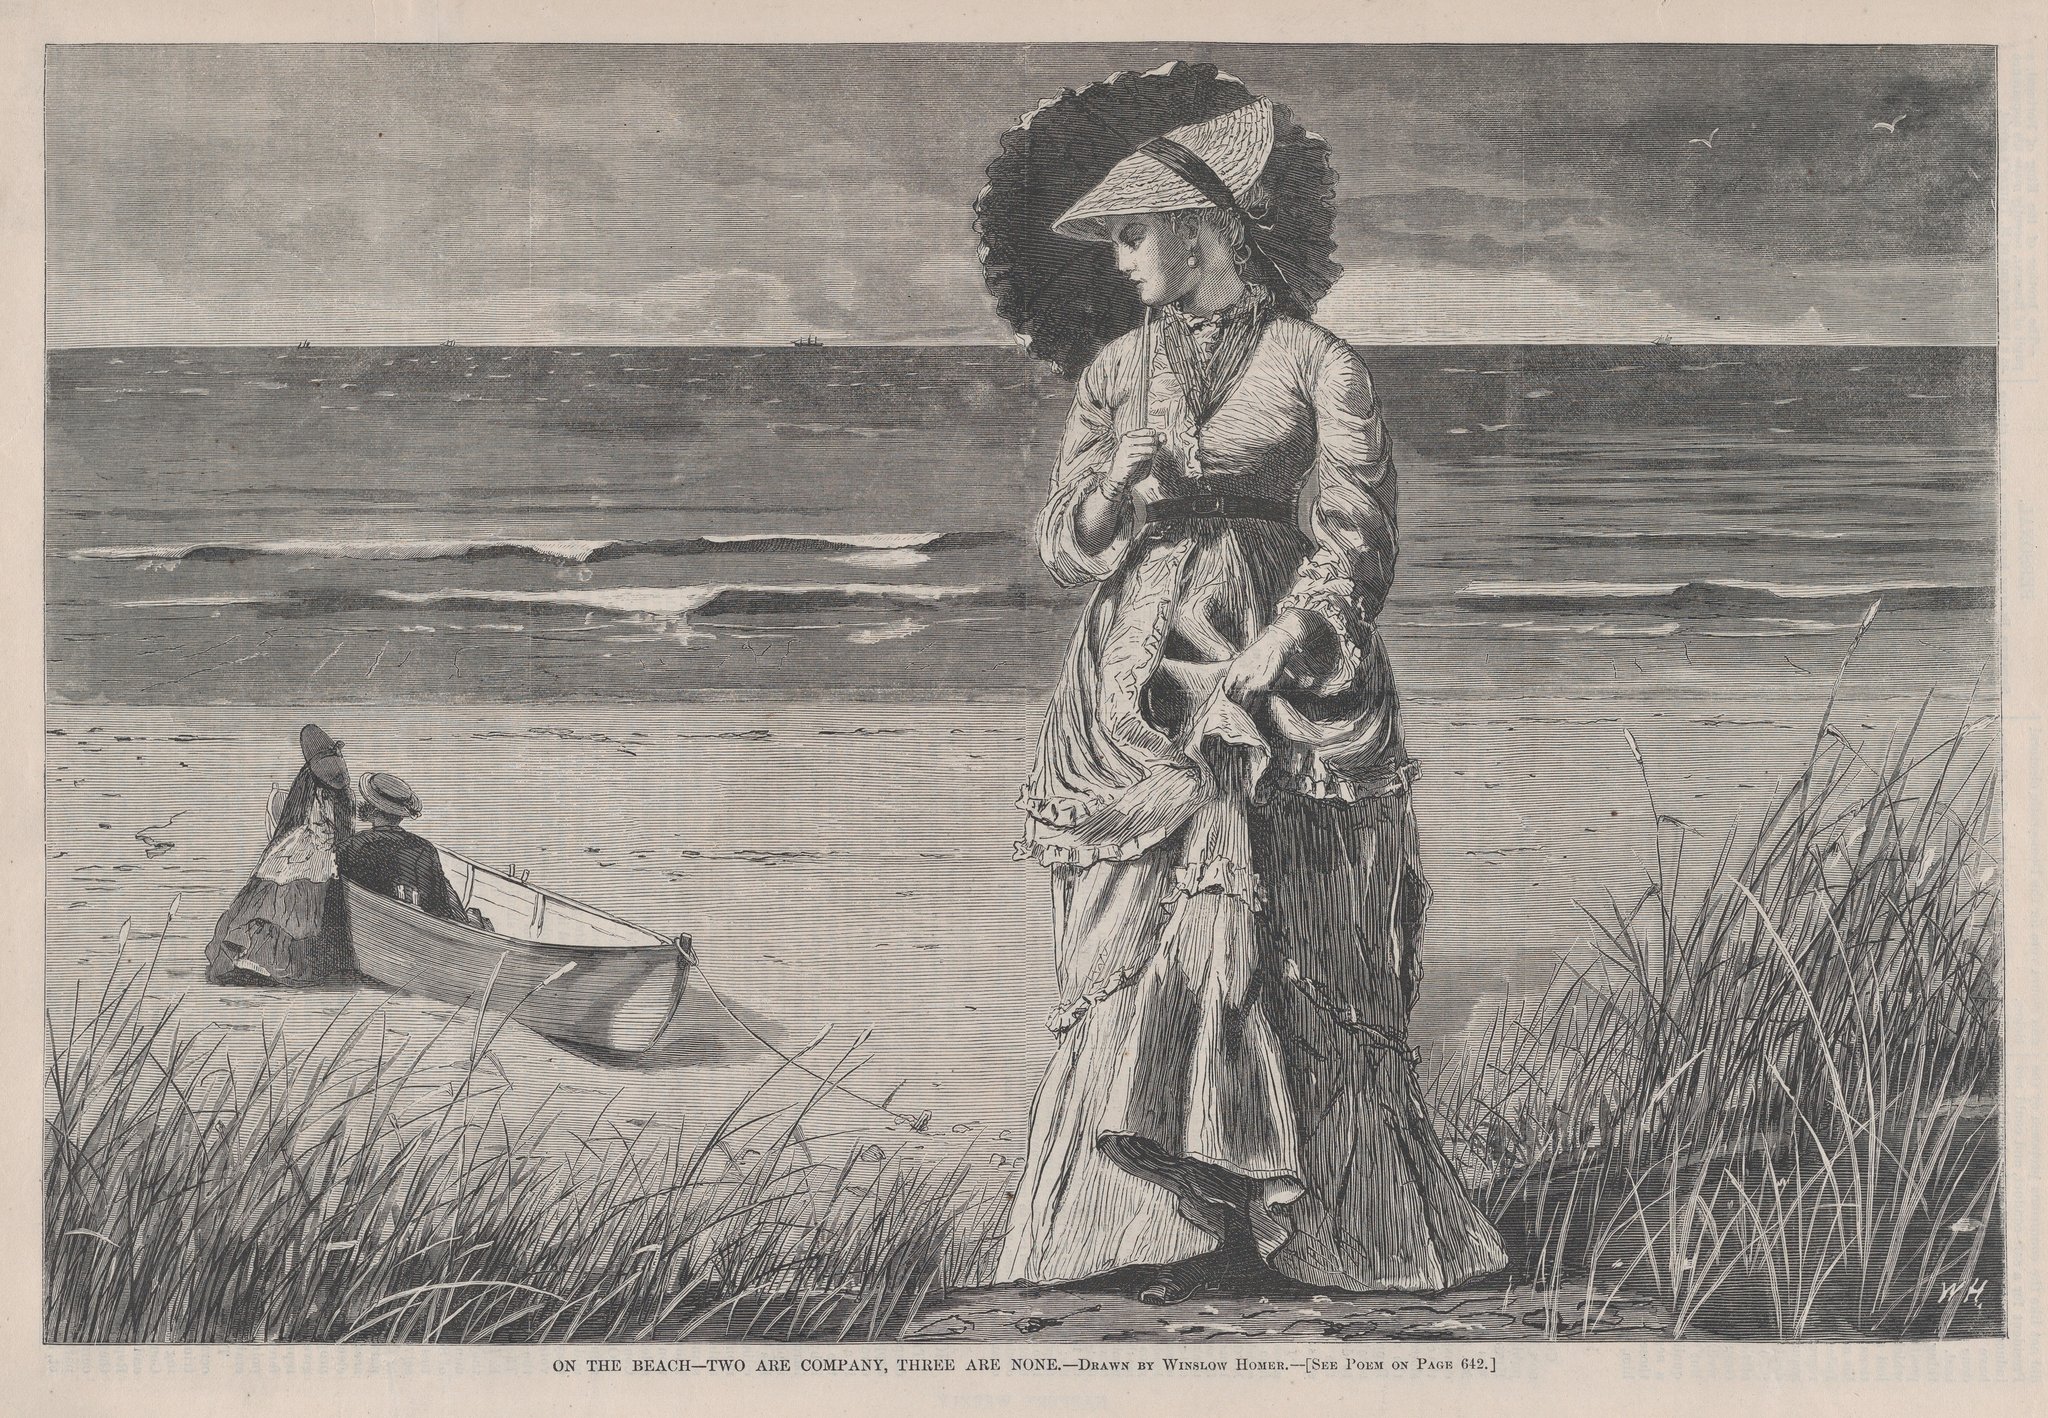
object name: print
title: On the Beach – Two are Company, Three are None, from "Harper's Weekly," Vol. XVI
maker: winslow homer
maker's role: artist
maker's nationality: american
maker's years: 1836-1910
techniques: engraving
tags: men,women,beaches,boats